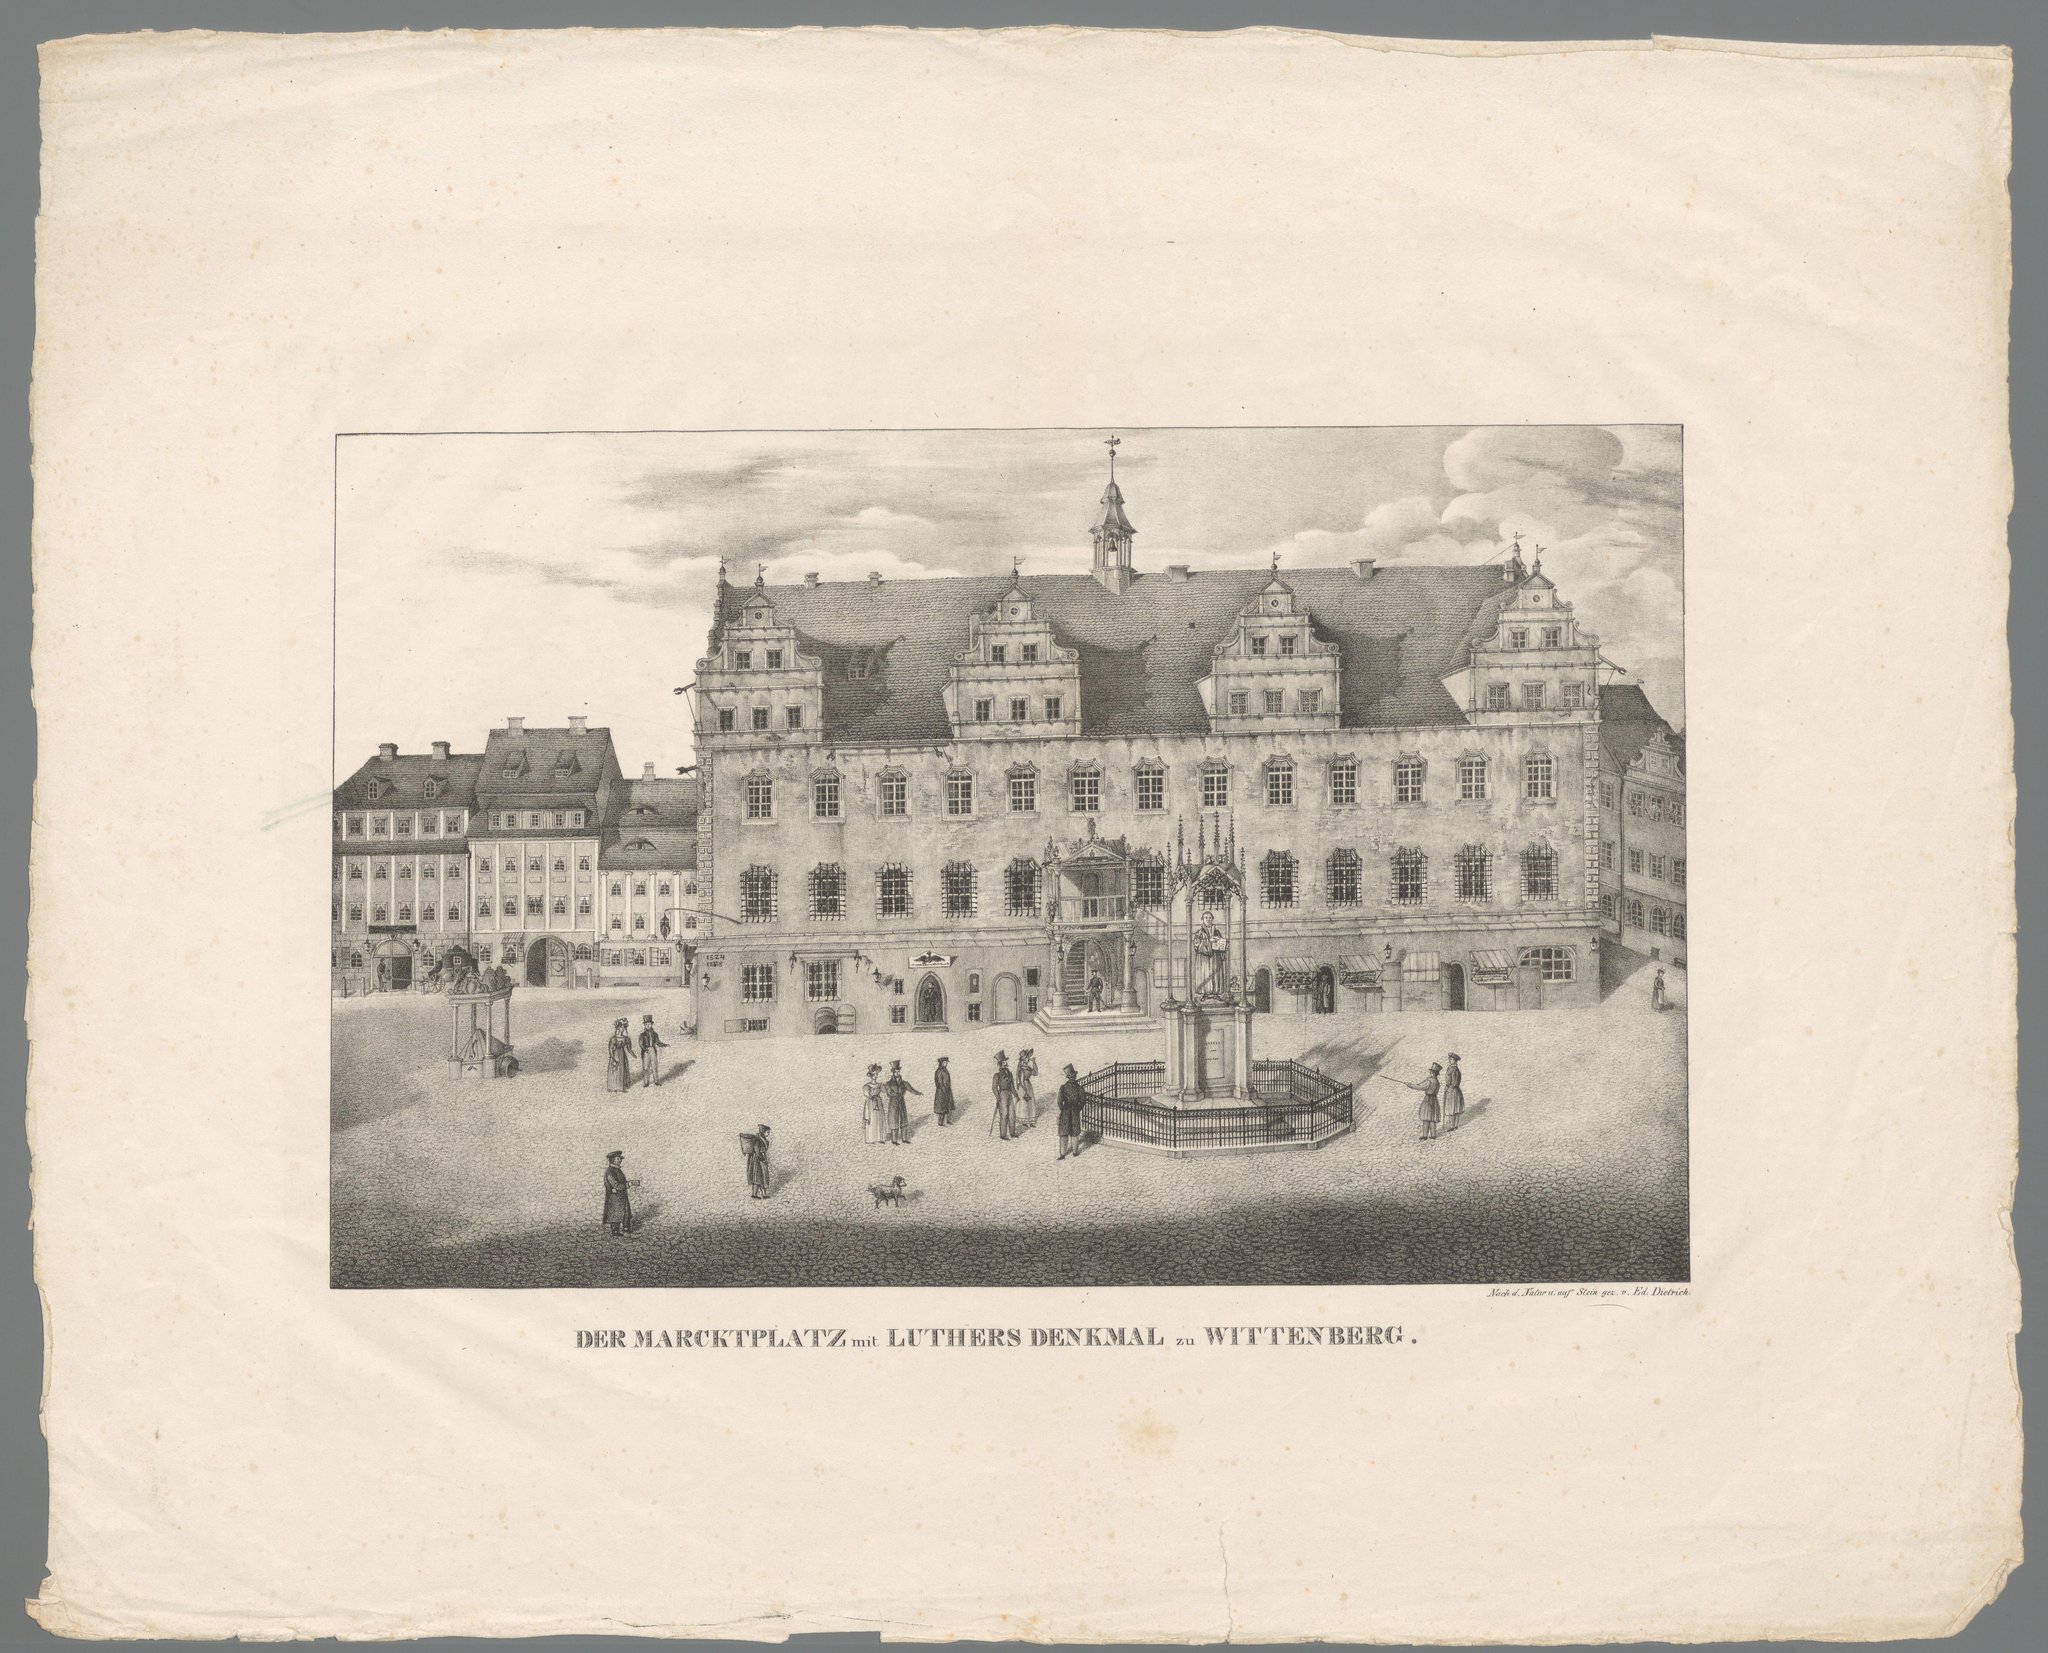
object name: print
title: Gezicht op het marktplein van Wittenberg met Luther-monument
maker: eduard dietrich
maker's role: painter, print maker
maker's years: 1803-1877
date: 1813-1877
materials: paper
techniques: lithograph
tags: monument, statue, village square, place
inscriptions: collector's mark: Lugt 2228